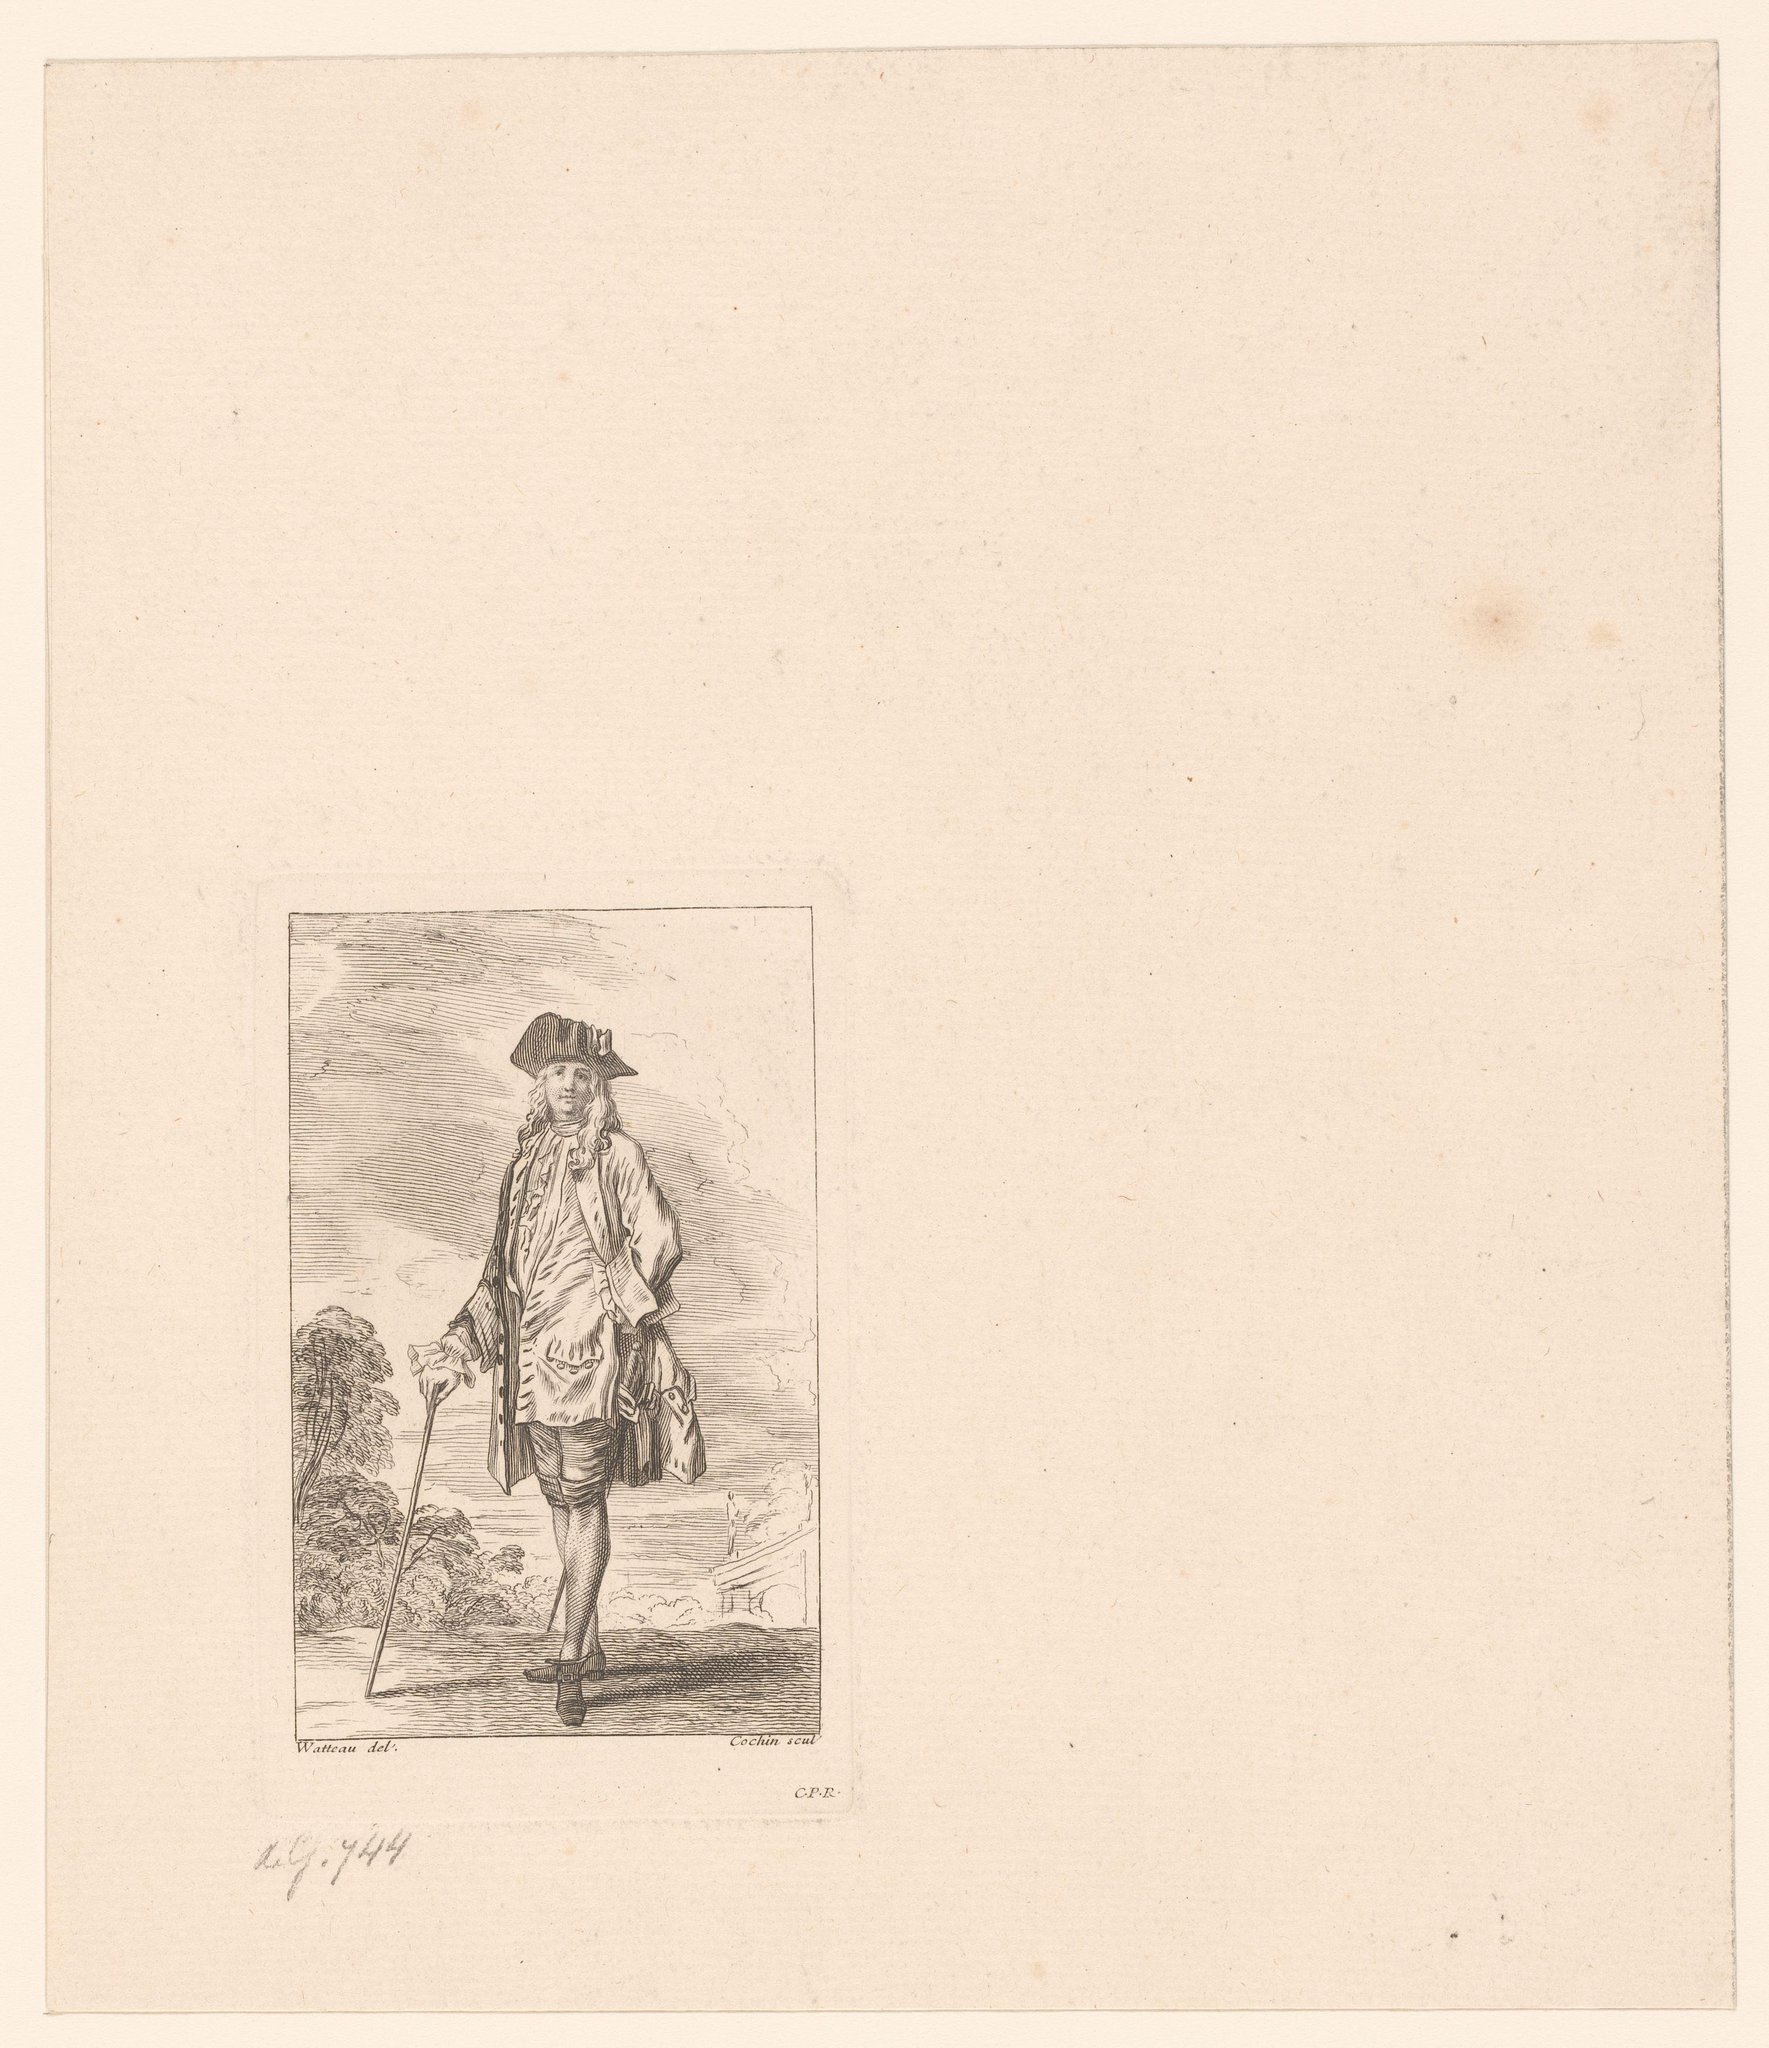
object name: costume print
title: Wandelaar met hoed en wandelstok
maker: jean antoine watteau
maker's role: draughtsman, print maker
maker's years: 1684-1721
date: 1698-1790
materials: paper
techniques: engraving, etching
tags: walking, hiking (recreation), adult man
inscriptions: collector's mark: Lugt 2228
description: Wandelaar gekleed in jas, vest en kniebroek. Op het hoofd een steek met kokarde, wandelstok in de rechterhand, linkerhand in vestzak, platte schoenen.